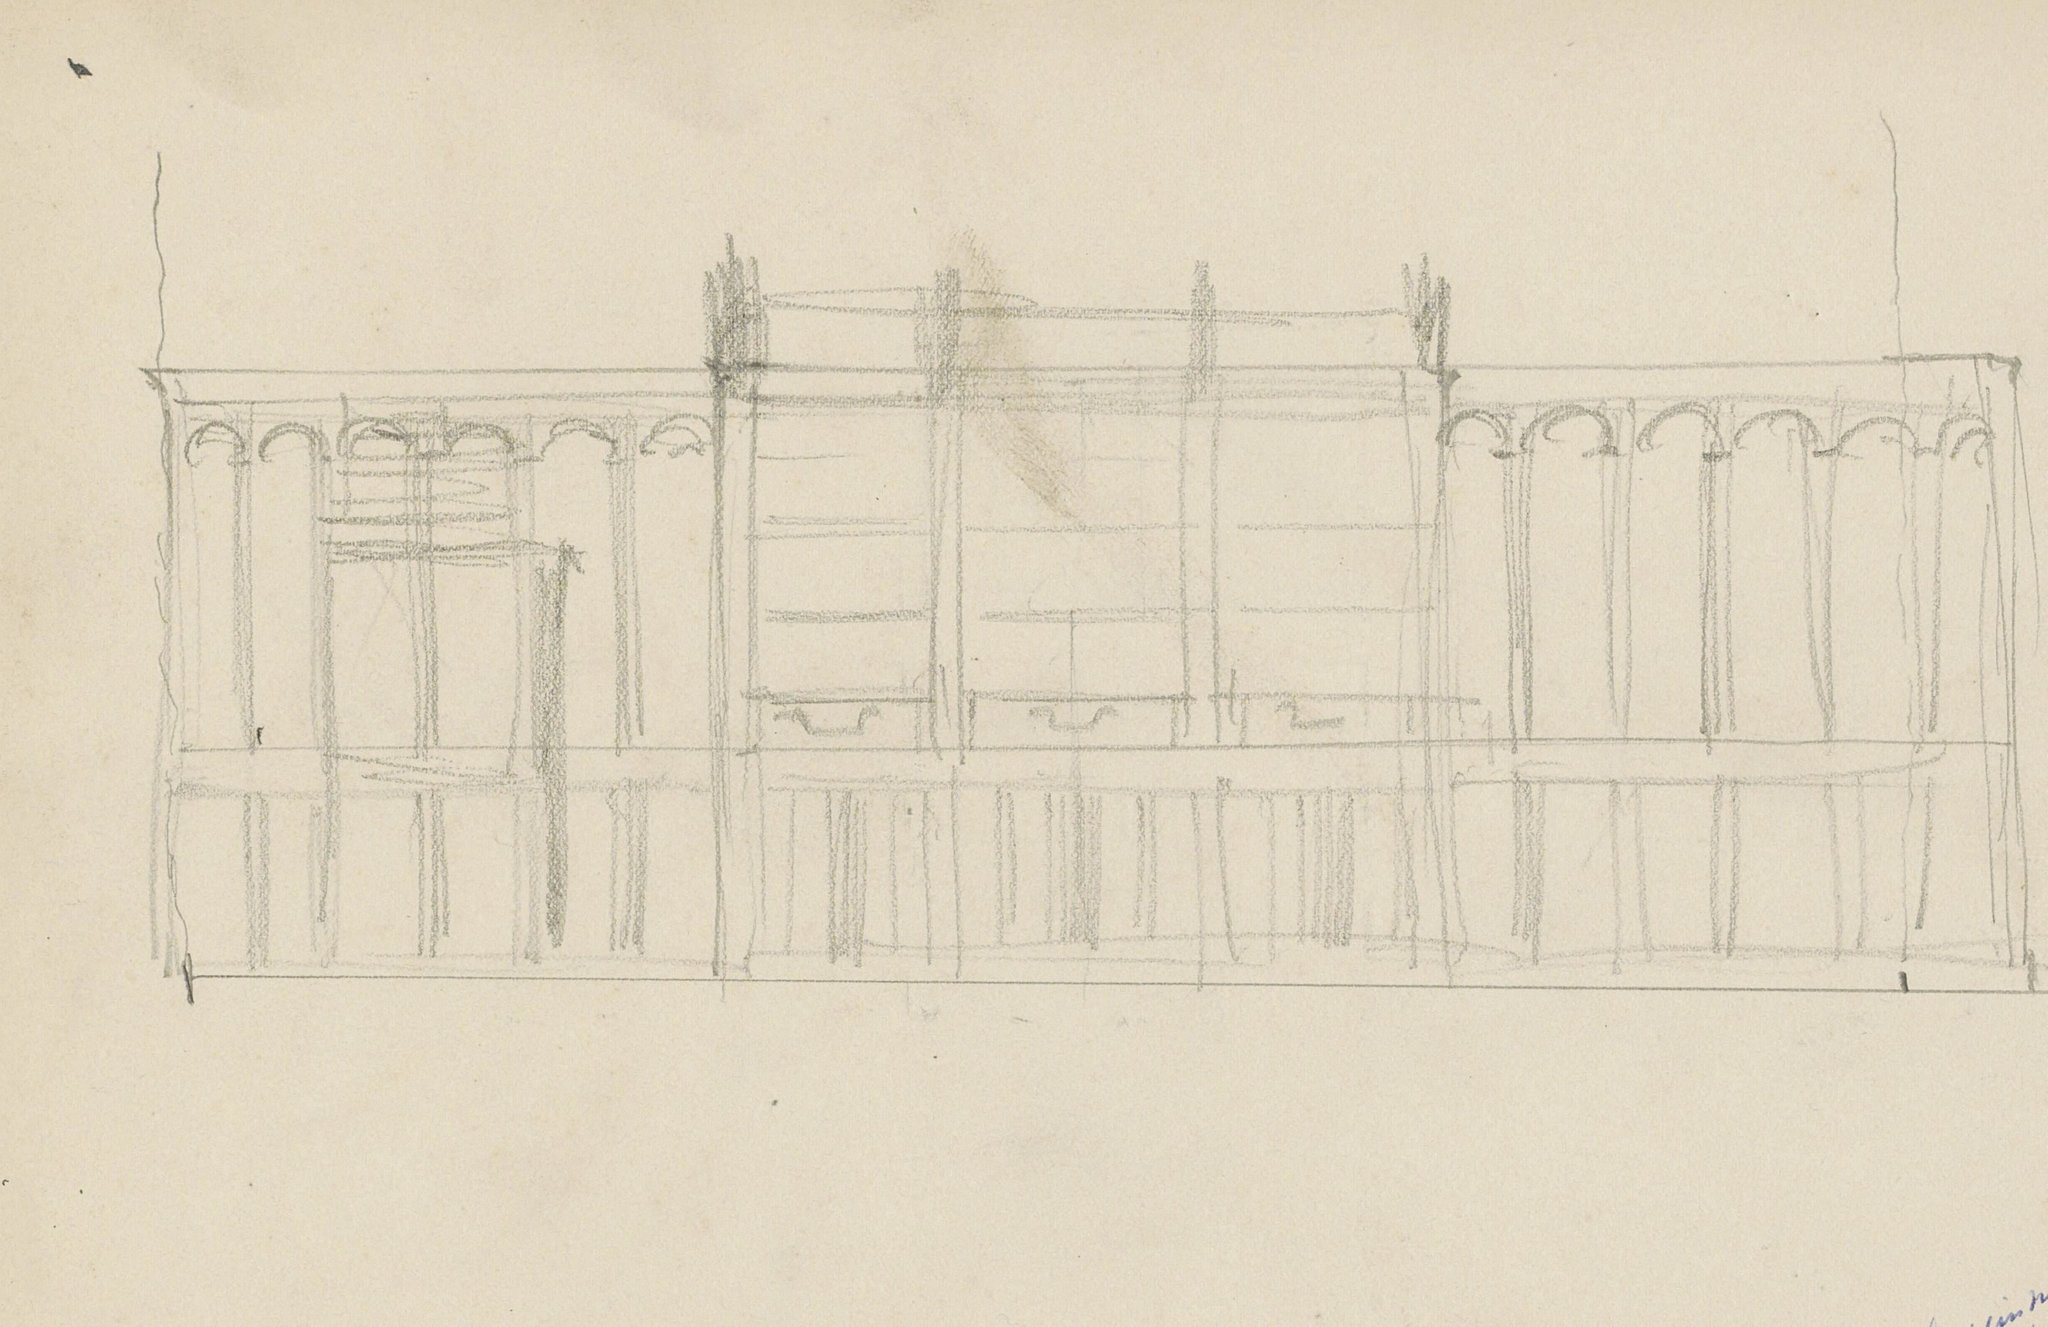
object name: sketchbook leaf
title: Ontwerp voor een wandbetimmering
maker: carel adolph lion cachet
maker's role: draughtsman, print maker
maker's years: 1864-1945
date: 1908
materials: paper, pencil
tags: wainscoting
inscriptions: annotation: ‘betimmering Her[...]/ dam[...] Mesdag/ Amsterdam/ zie foto’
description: Blad 5 recto uit een schetsboek met 25 bladen.